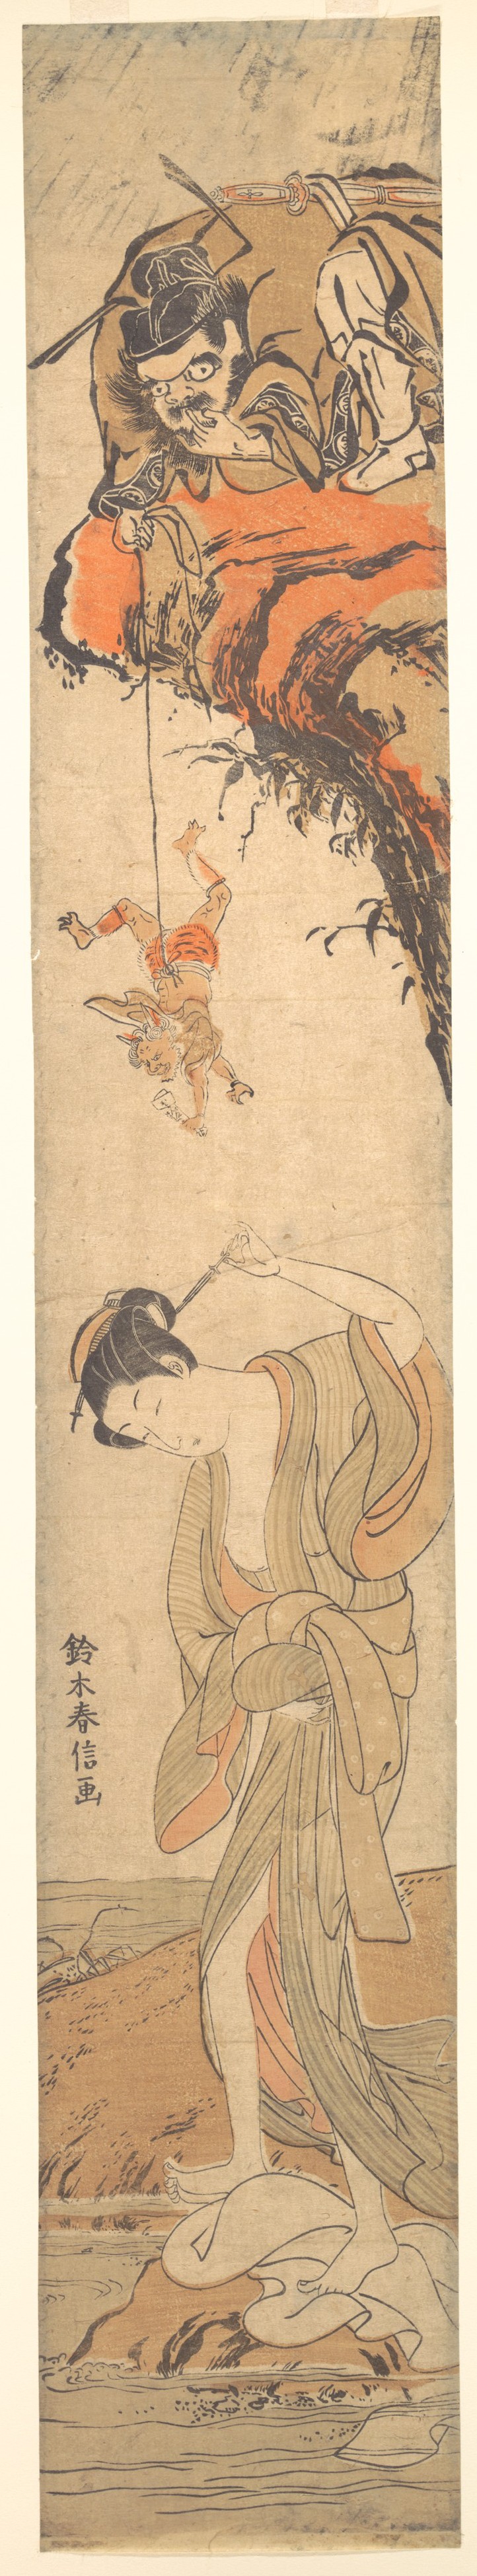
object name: print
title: The Immortal Kume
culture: japanese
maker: suzuki harunobu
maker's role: artist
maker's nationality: japanese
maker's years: 1725-1770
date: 1760-1769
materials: ink, paper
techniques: hashira, woodblock print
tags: women,demons